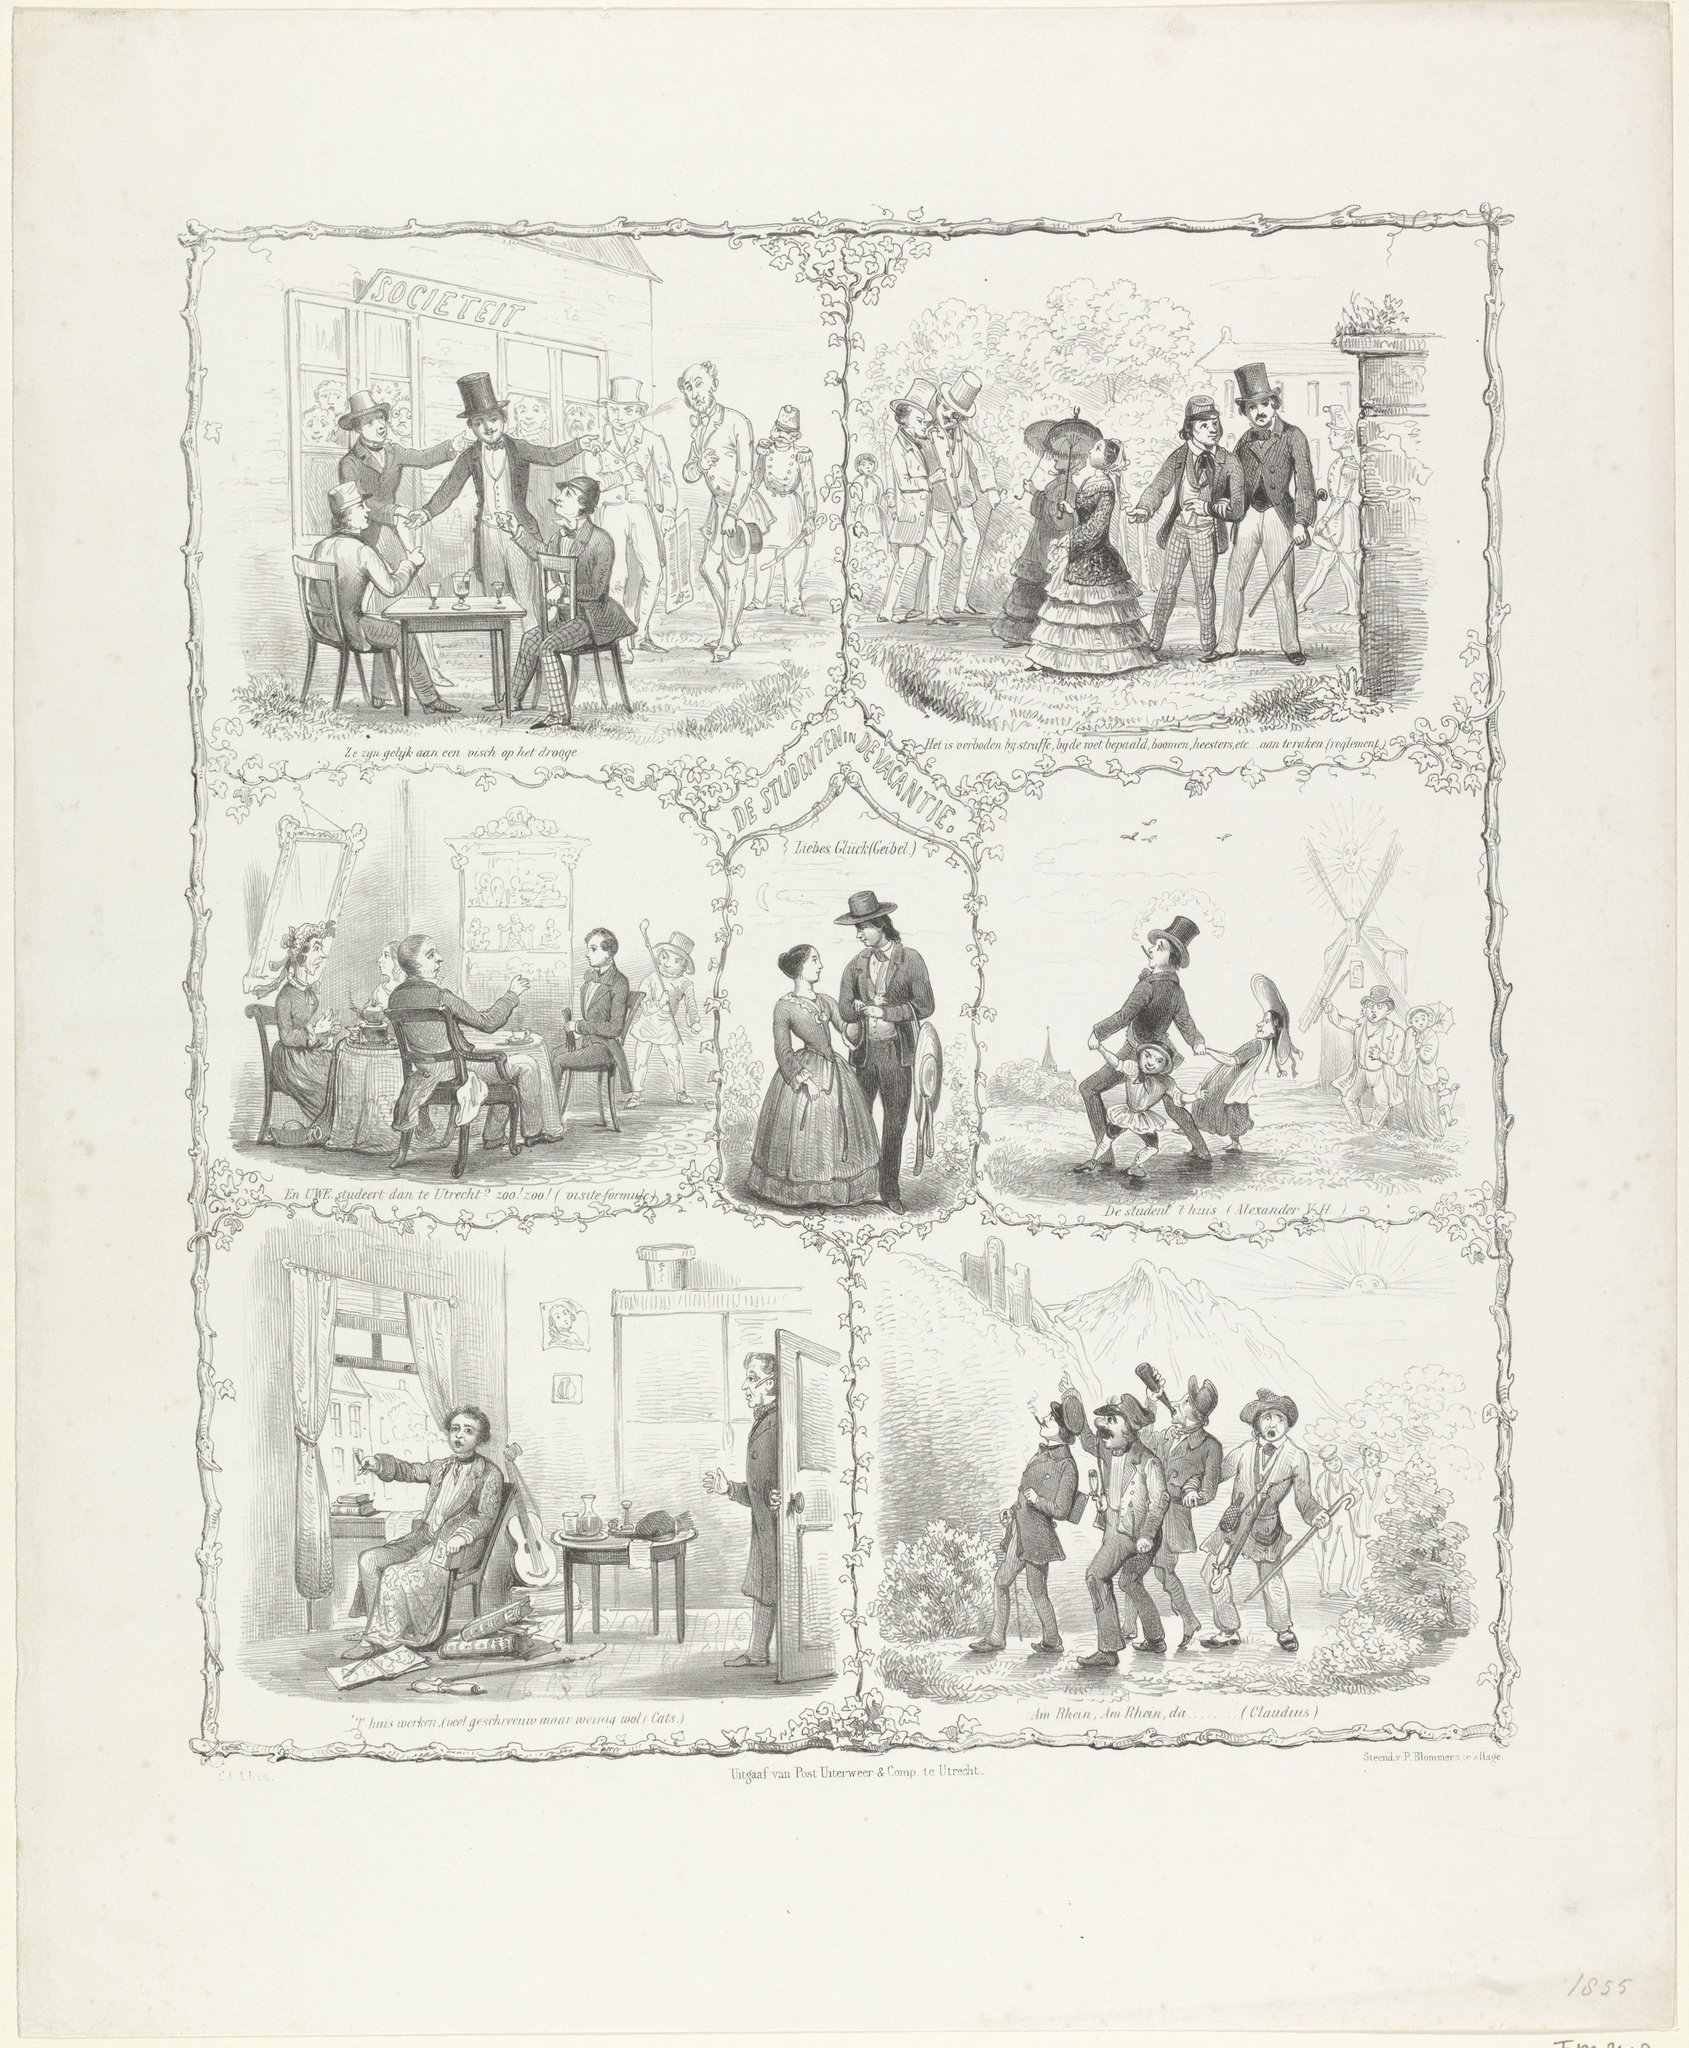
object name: cartoon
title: De Studenten in De Vacantie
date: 1855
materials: paper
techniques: lithograph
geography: utrecht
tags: student vacation, utrecht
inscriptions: collector's mark: Lugt 2228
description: Spotprent uit de studentenalmanak van de Universiteit van Utrecht van het jaar 1855. Blad met zeven voorstellingen van hoe studenten de vakantie doorbrengen.